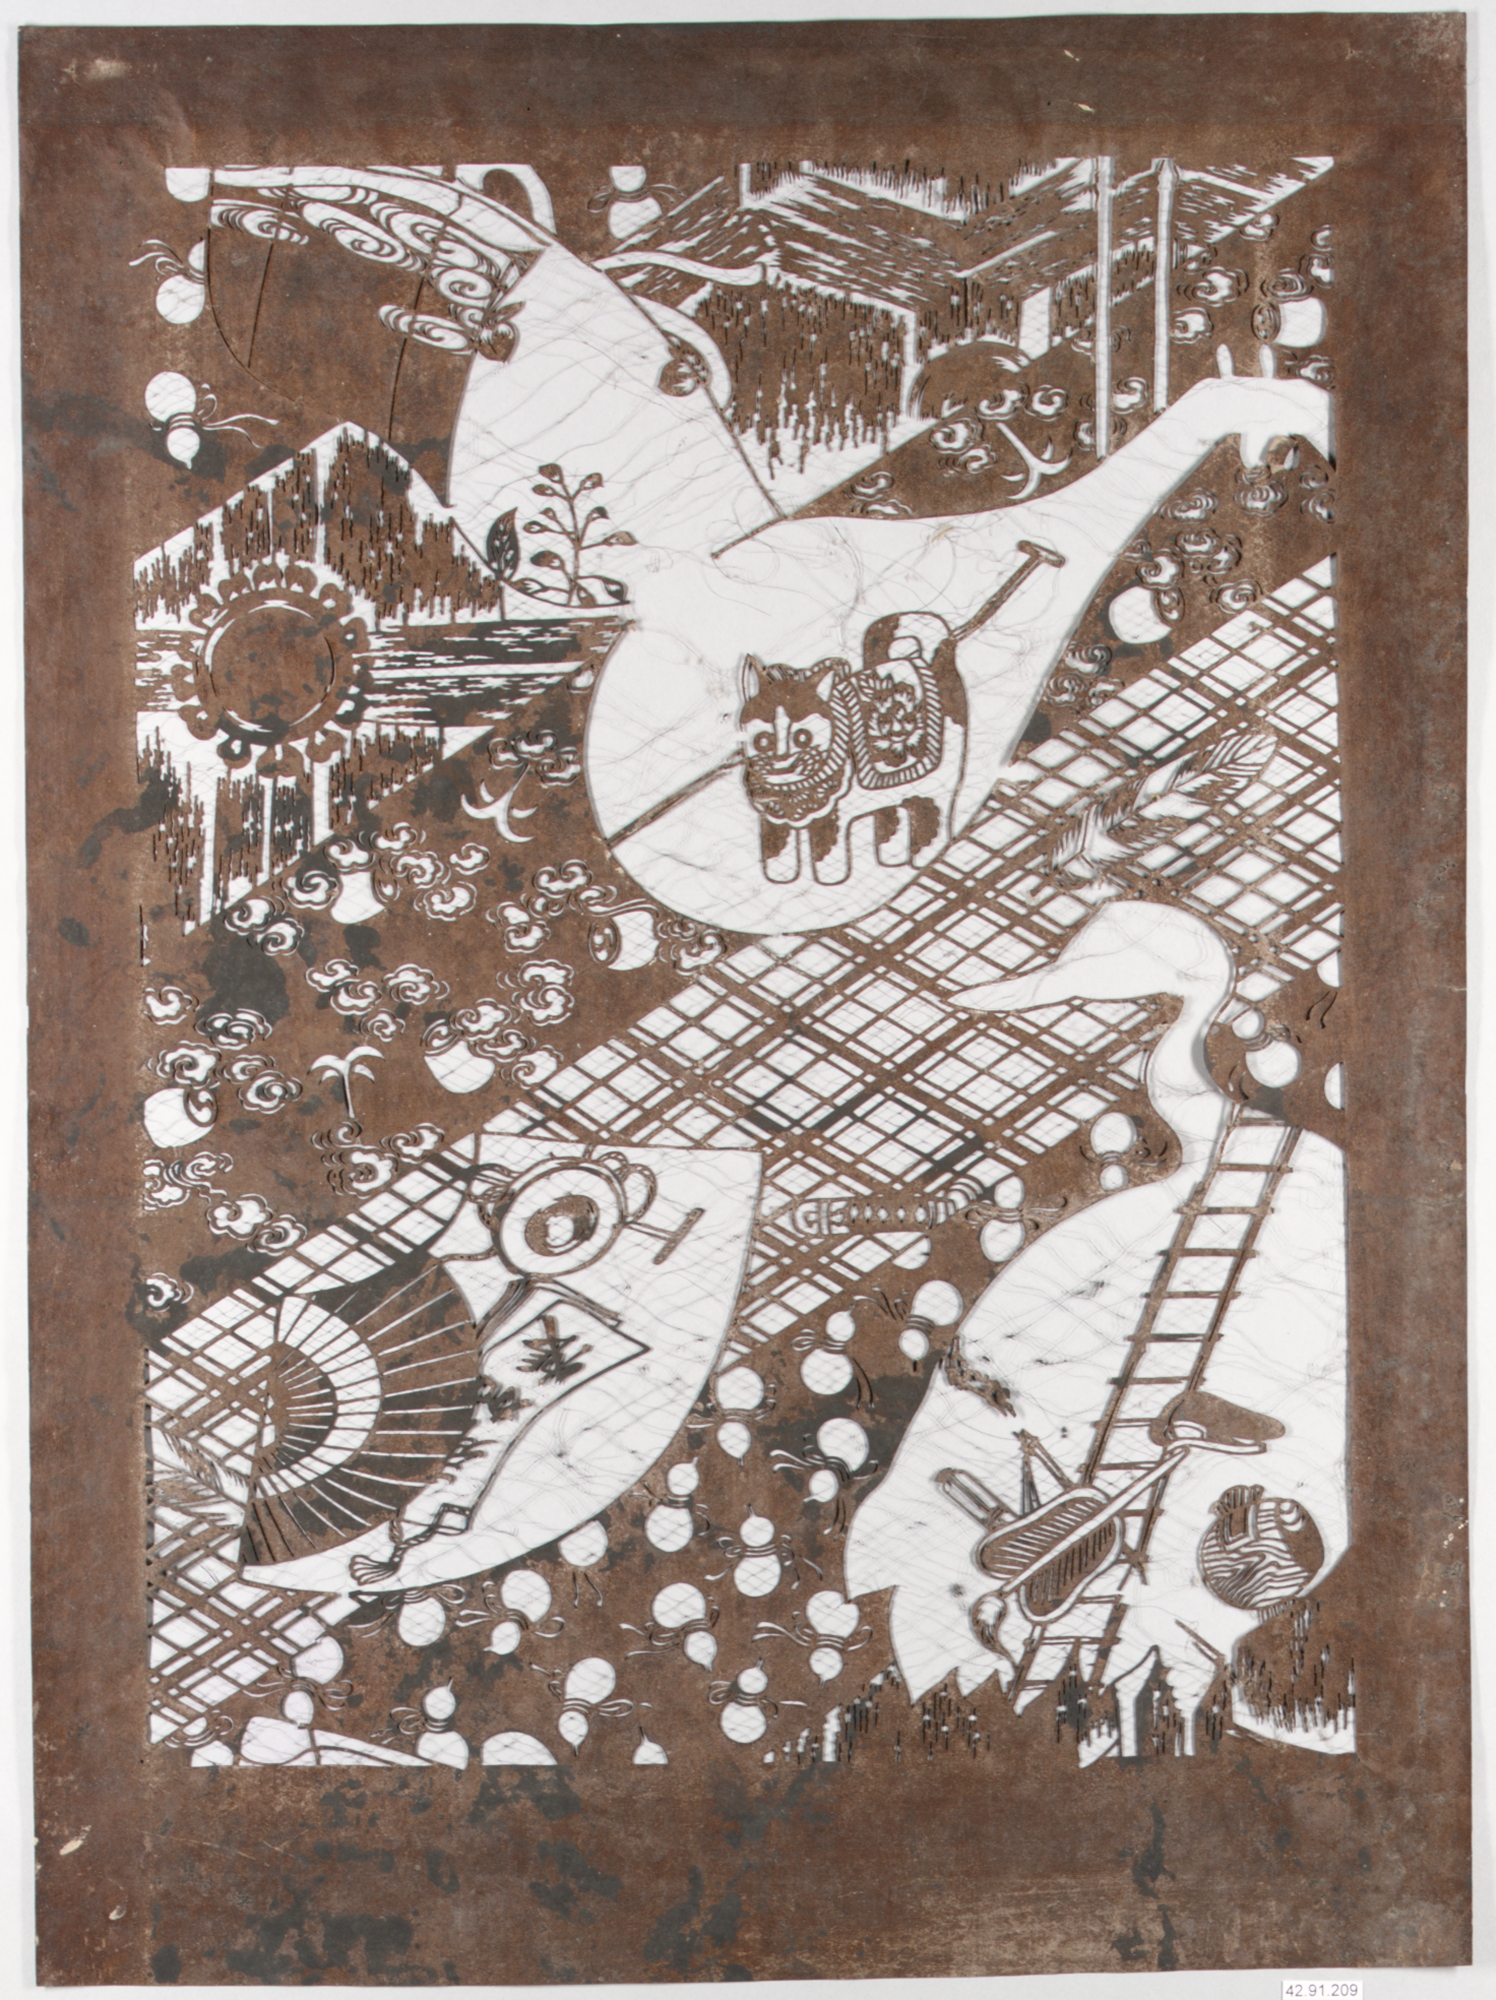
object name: stencil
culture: japanese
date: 1801-1900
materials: paper, silk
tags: birds,fans,cats,ladders